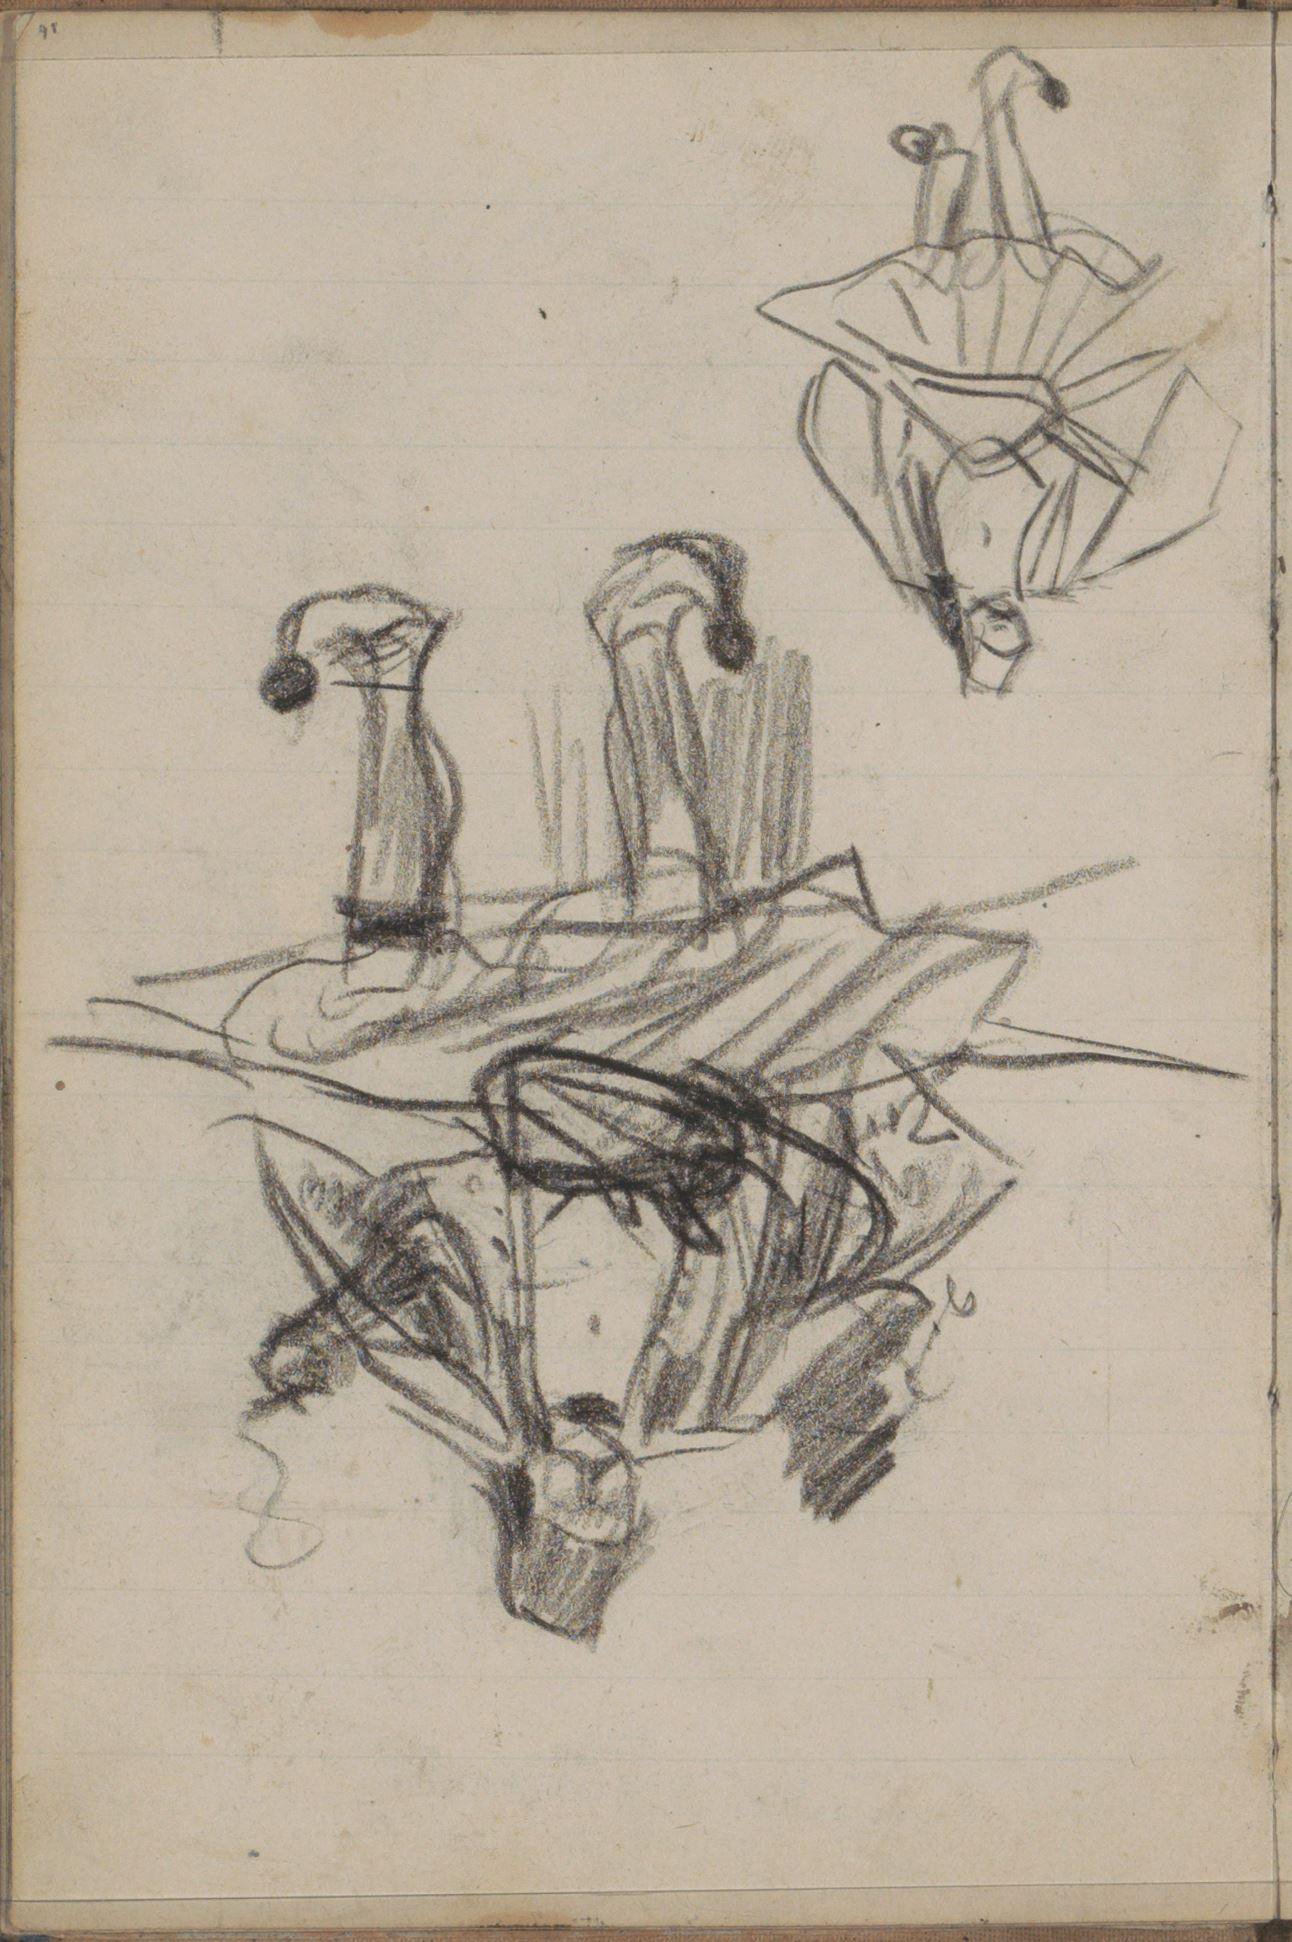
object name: sketchbook leaf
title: Figuurstudies van een man in oosterse kleding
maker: marius bauer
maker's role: draughtsman, print maker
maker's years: 1867-1932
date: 1888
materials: chalk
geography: istanbul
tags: asiatic races and peoples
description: Pagina 41 uit een schetsboek met 58 bladen.